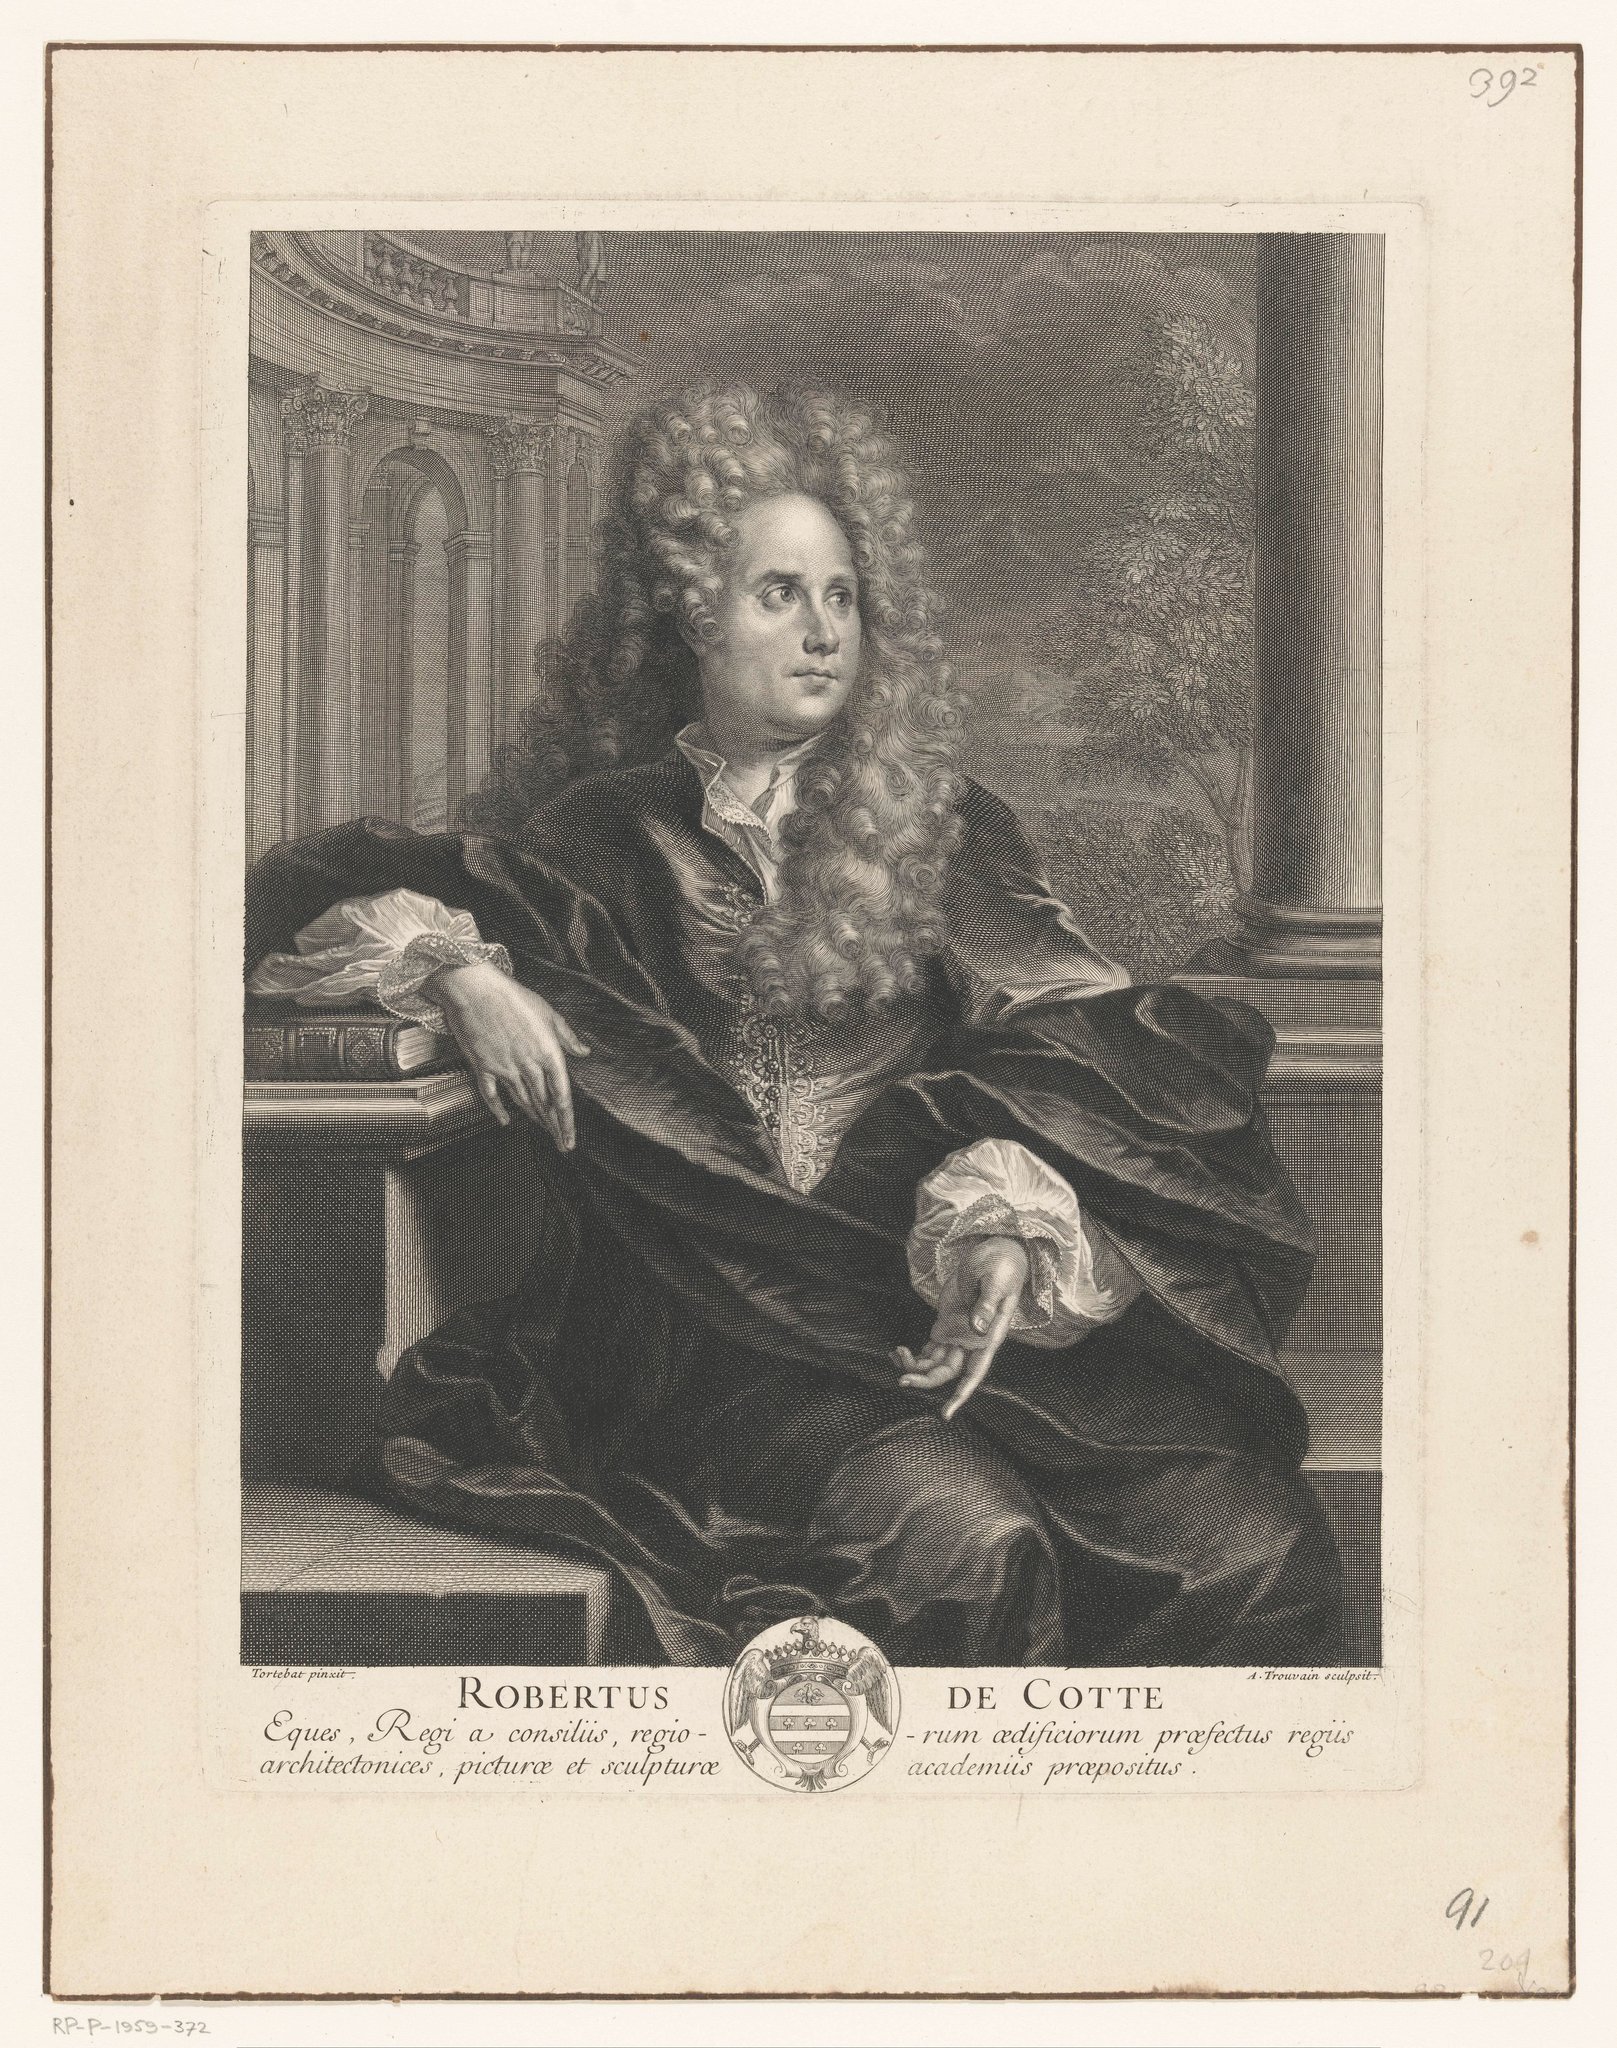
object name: print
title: Portret van Robert de Cotte, leunend op een boek in klassieke architectuur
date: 1666-1708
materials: paper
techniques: engraving, etching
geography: france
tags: paris, historical persons, portrait, self-portrait of architect, wig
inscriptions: collector's mark: Lugt 2228